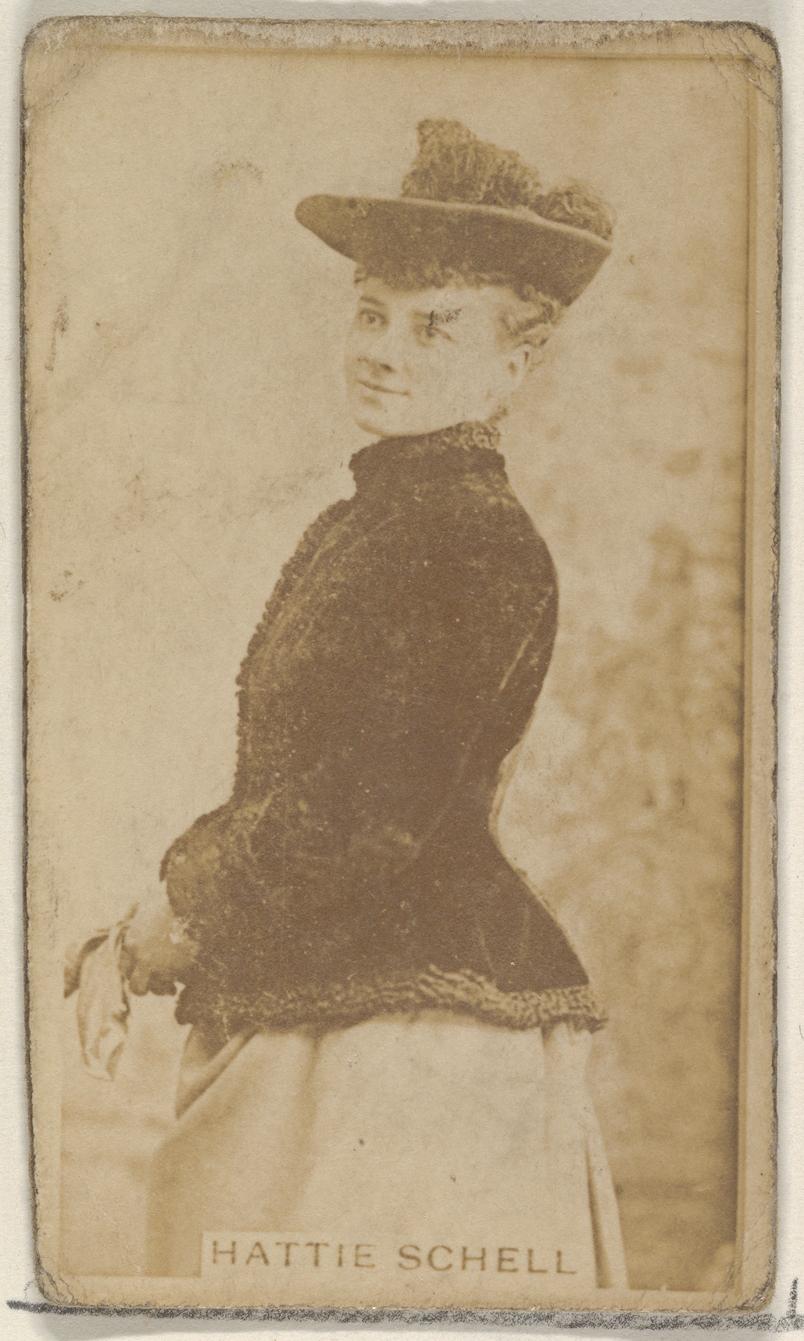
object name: photograph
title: Hattie Schell, from the Actors and Actresses series (N45, Type 8) for Virginia Brights Cigarettes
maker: allen & ginter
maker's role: publisher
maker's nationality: american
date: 1888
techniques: albumen silver print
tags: portraits,women,actresses